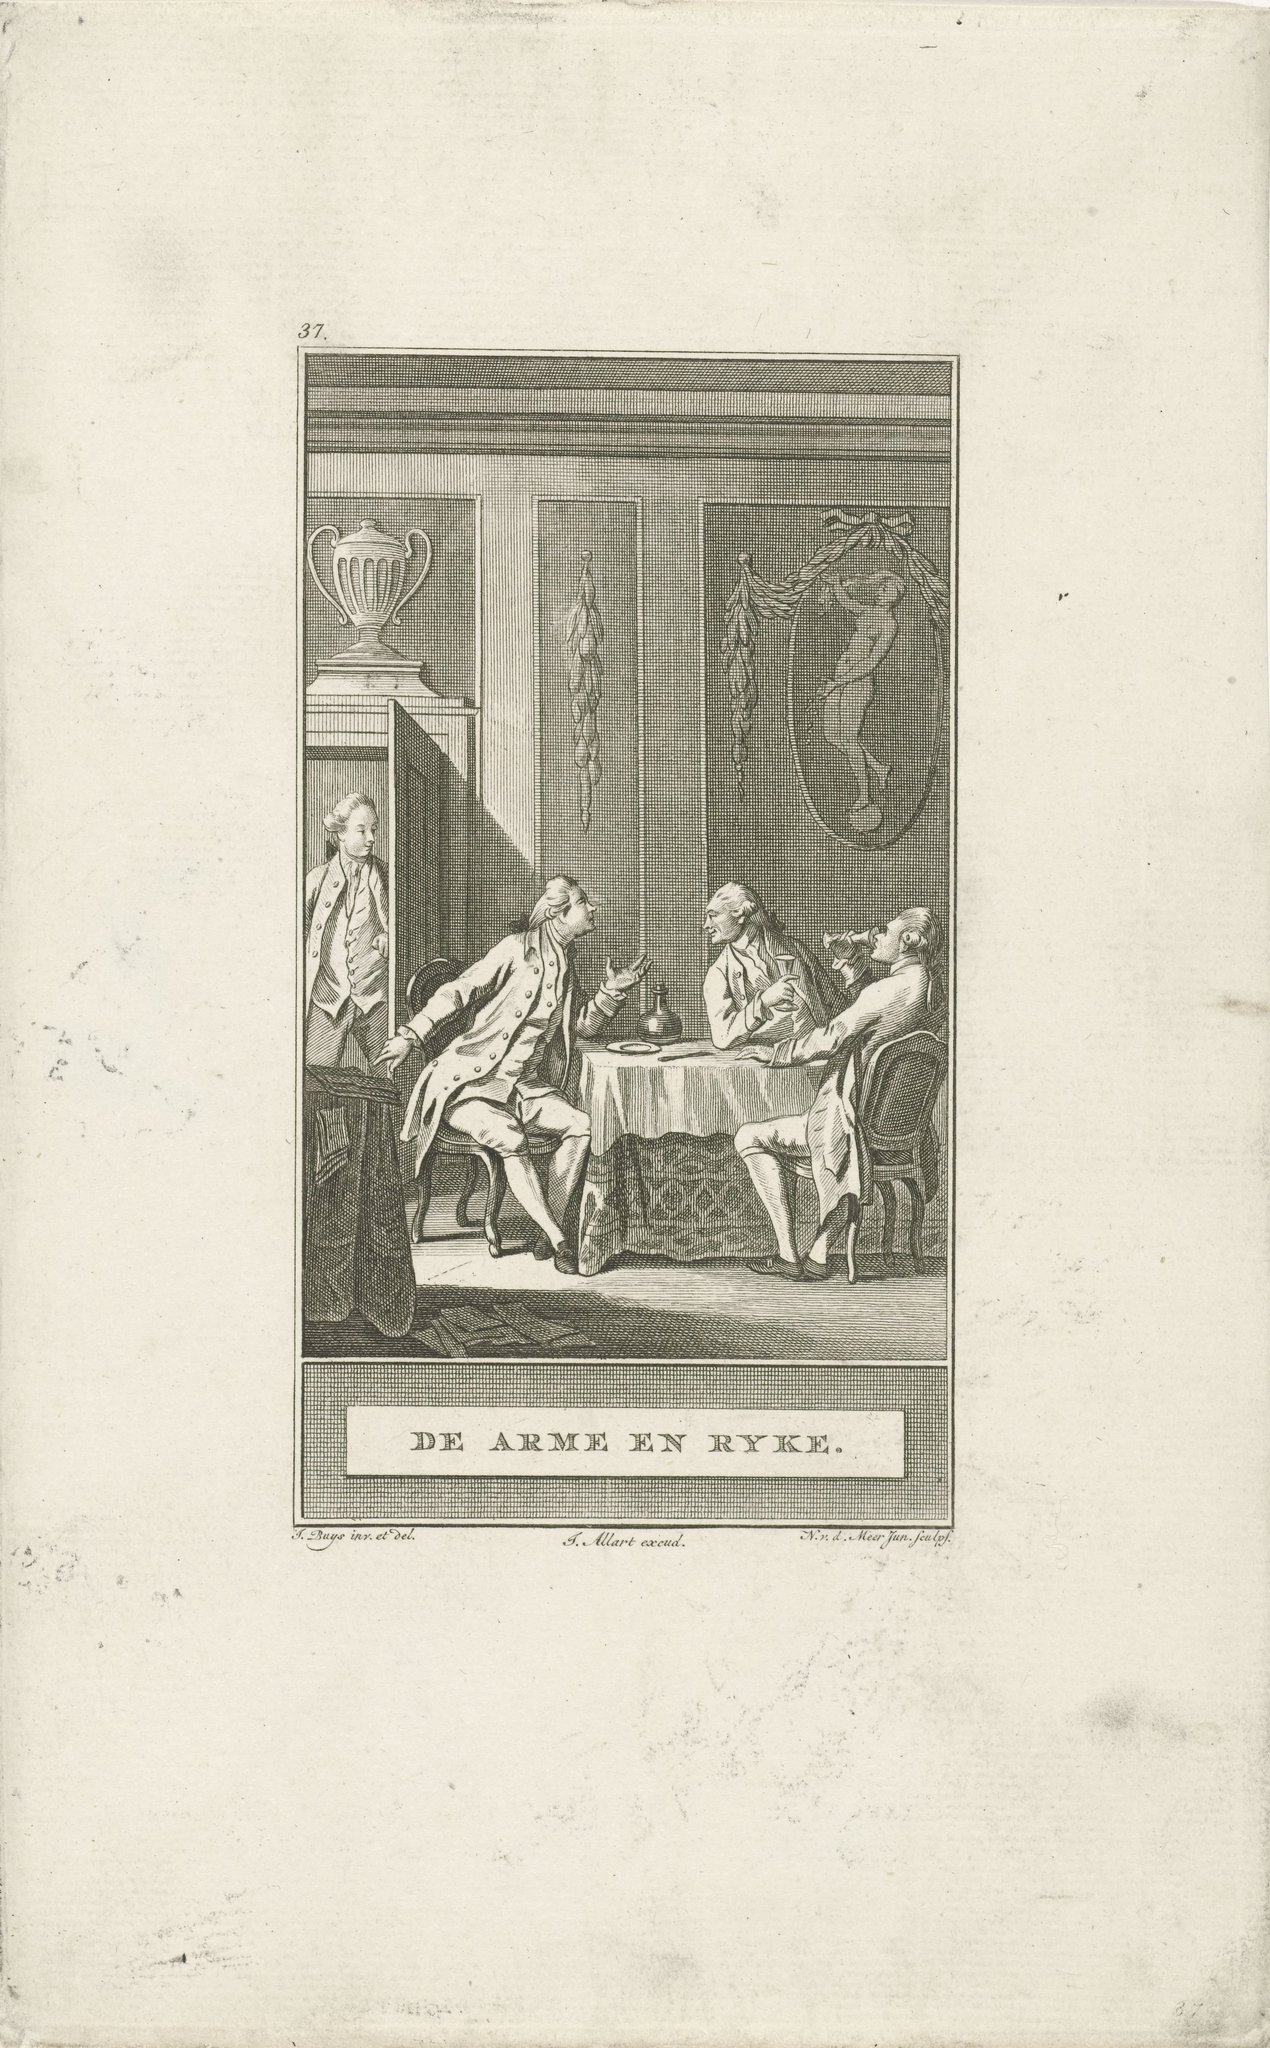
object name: book illustration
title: De arme en ryke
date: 1778-1785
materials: paper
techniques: etching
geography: amsterdam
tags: the rich, luck, fortune, lot; 'fato', 'fortuna', 'fortuna aurea', 'fortuna buona', 'fortuna pacifica overo clemente', 'sorte' (ripa), drinking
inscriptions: collector's mark: Lugt 2228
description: Prent bij: Gellert, Christian Fürchtegott. Fabelen en vertelsels. 3 dln. Amsterdam: Pieter Meyer, 1772-1774. De prenten bij deze publicatie werden later uitgegeven. De exemplaren uitgegeven door de weduwe Jacobus Loveringh & Johannes Allart tussen 1777 en 1778, de exemplaren uitgegeven door alleen Johannes Allart tussen 1778 en 1785.